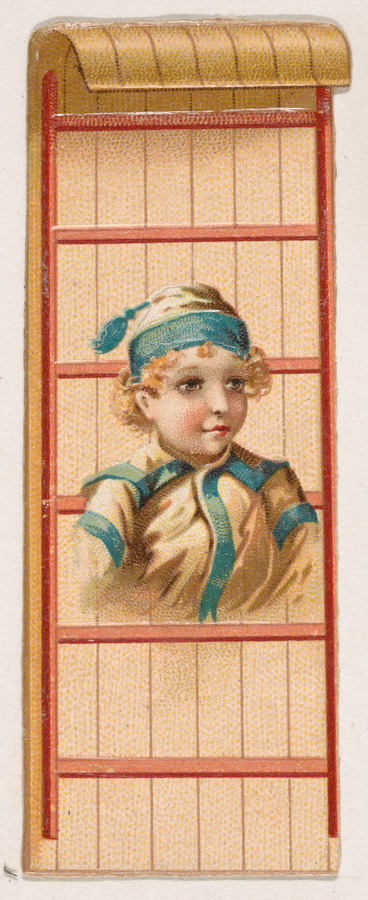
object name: print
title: Toboggan, from the Novelties series (N228, Type 4) issued by Kinney Bros.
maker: kinney brothers tobacco company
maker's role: publisher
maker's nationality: american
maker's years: 1869-2011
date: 1889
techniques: color lithograph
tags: girls